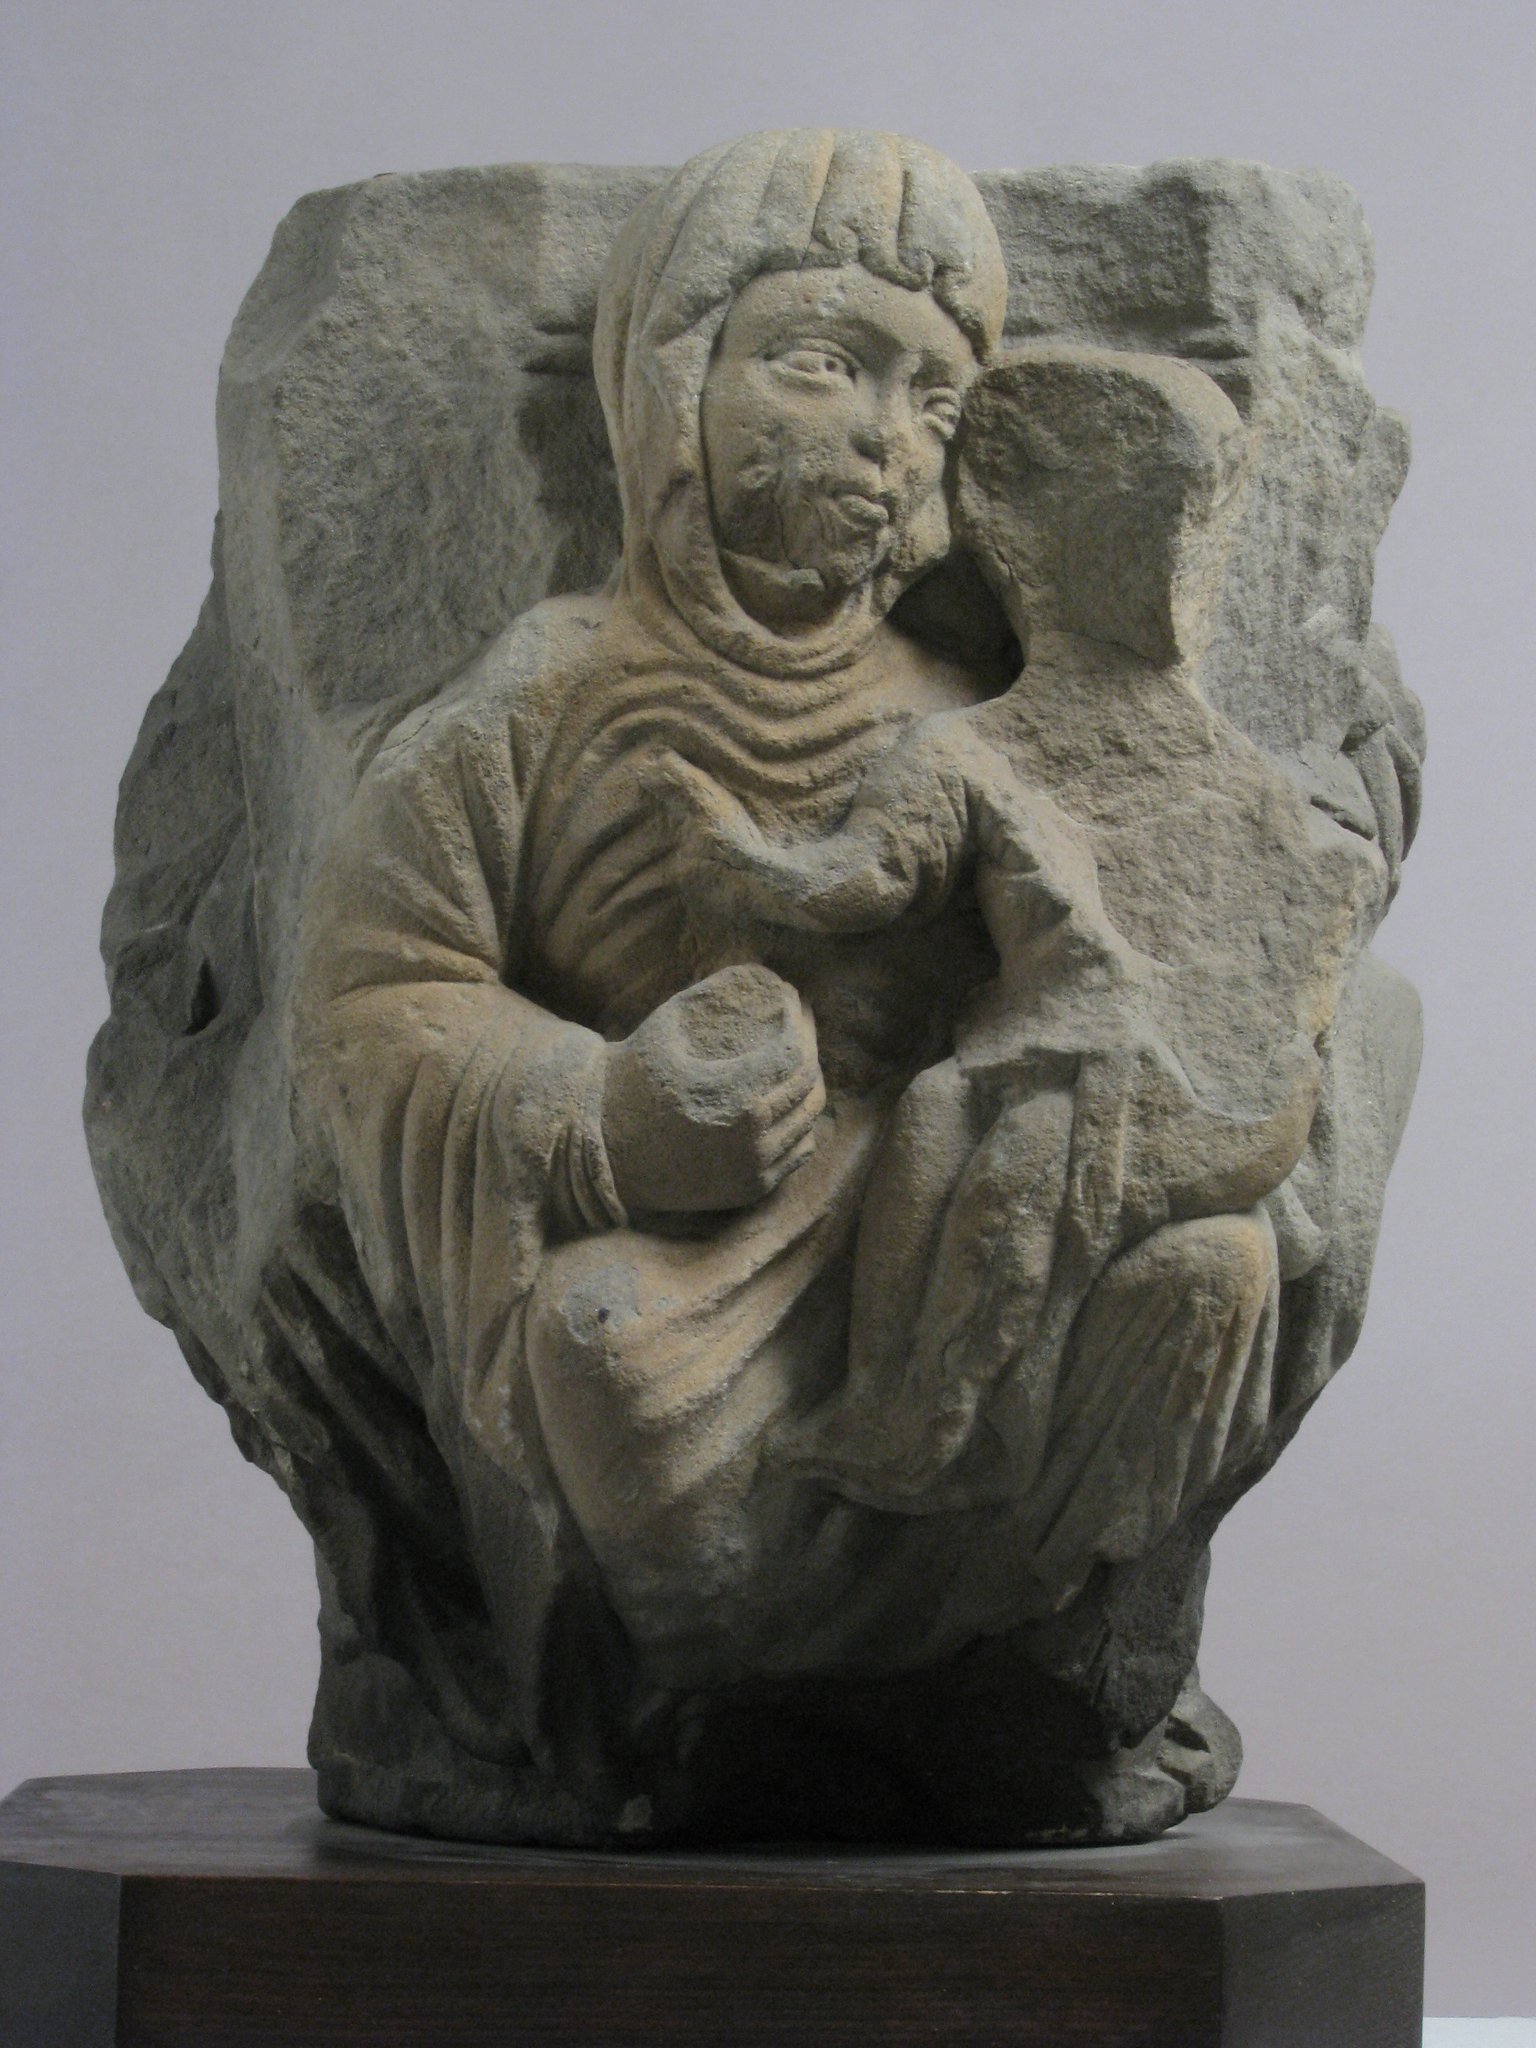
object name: capital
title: Capital with Adoration of the Magi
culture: french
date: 1151-1200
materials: limestone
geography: france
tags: madonna and child